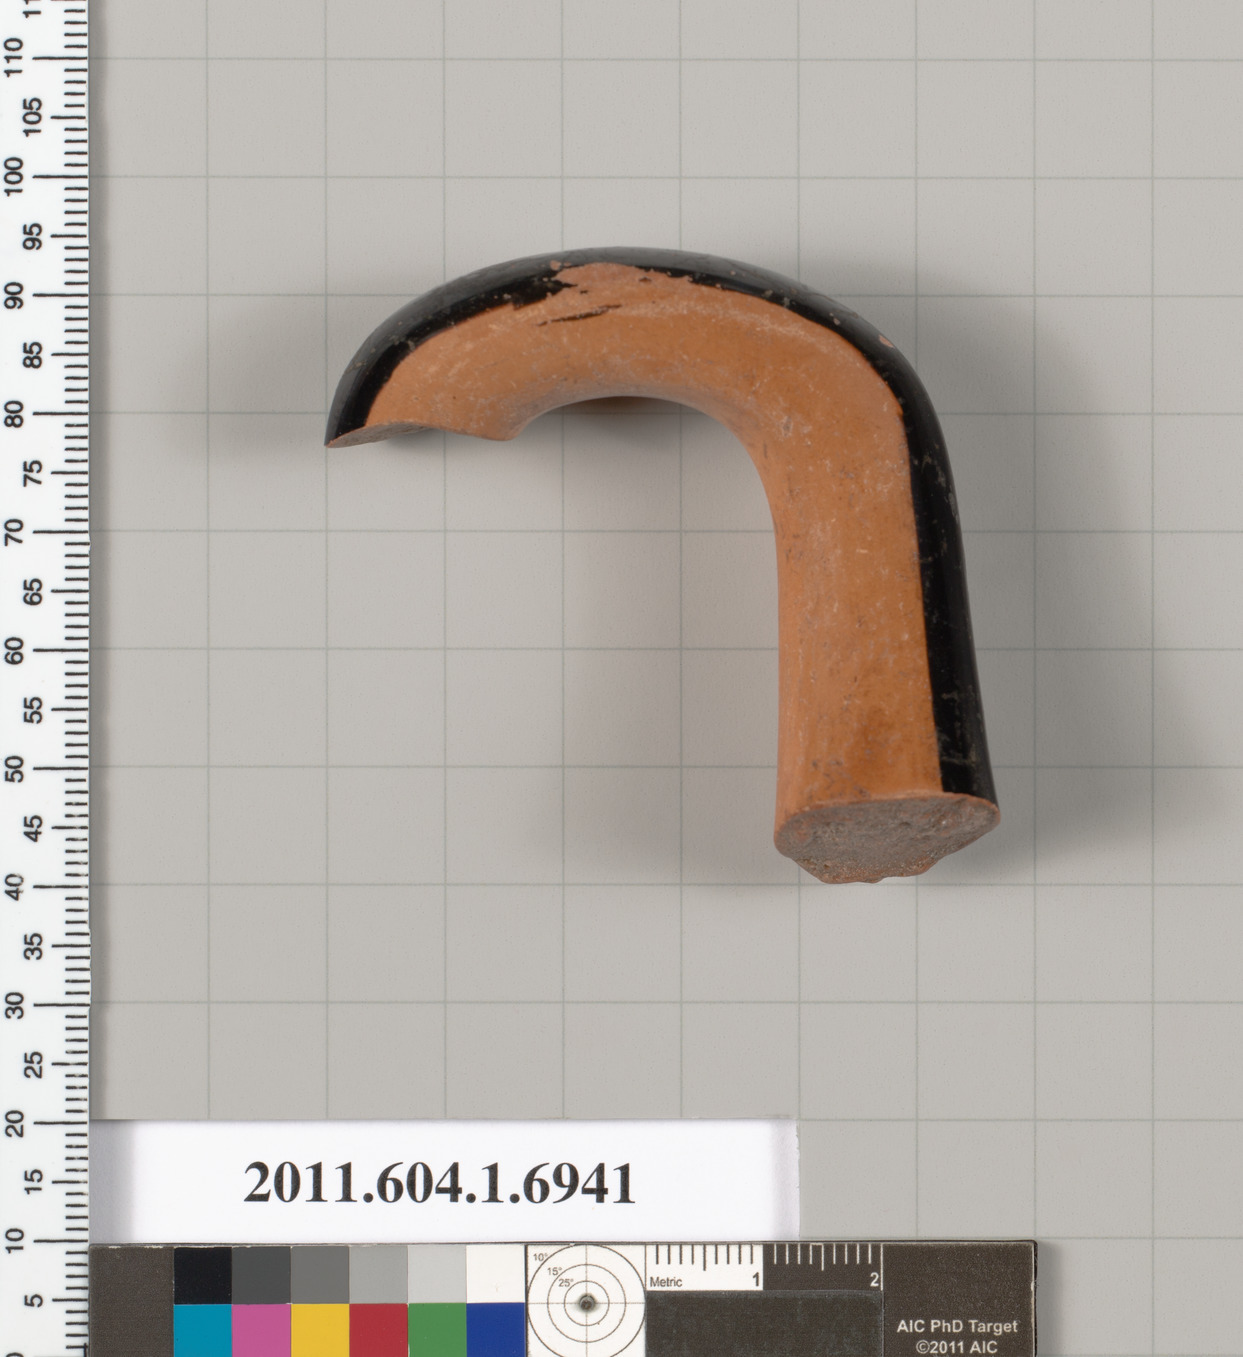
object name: kylix fragment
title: Terracotta fragment of a kylix (drinking cup)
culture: greek, attic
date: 490-470 BCE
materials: terracotta